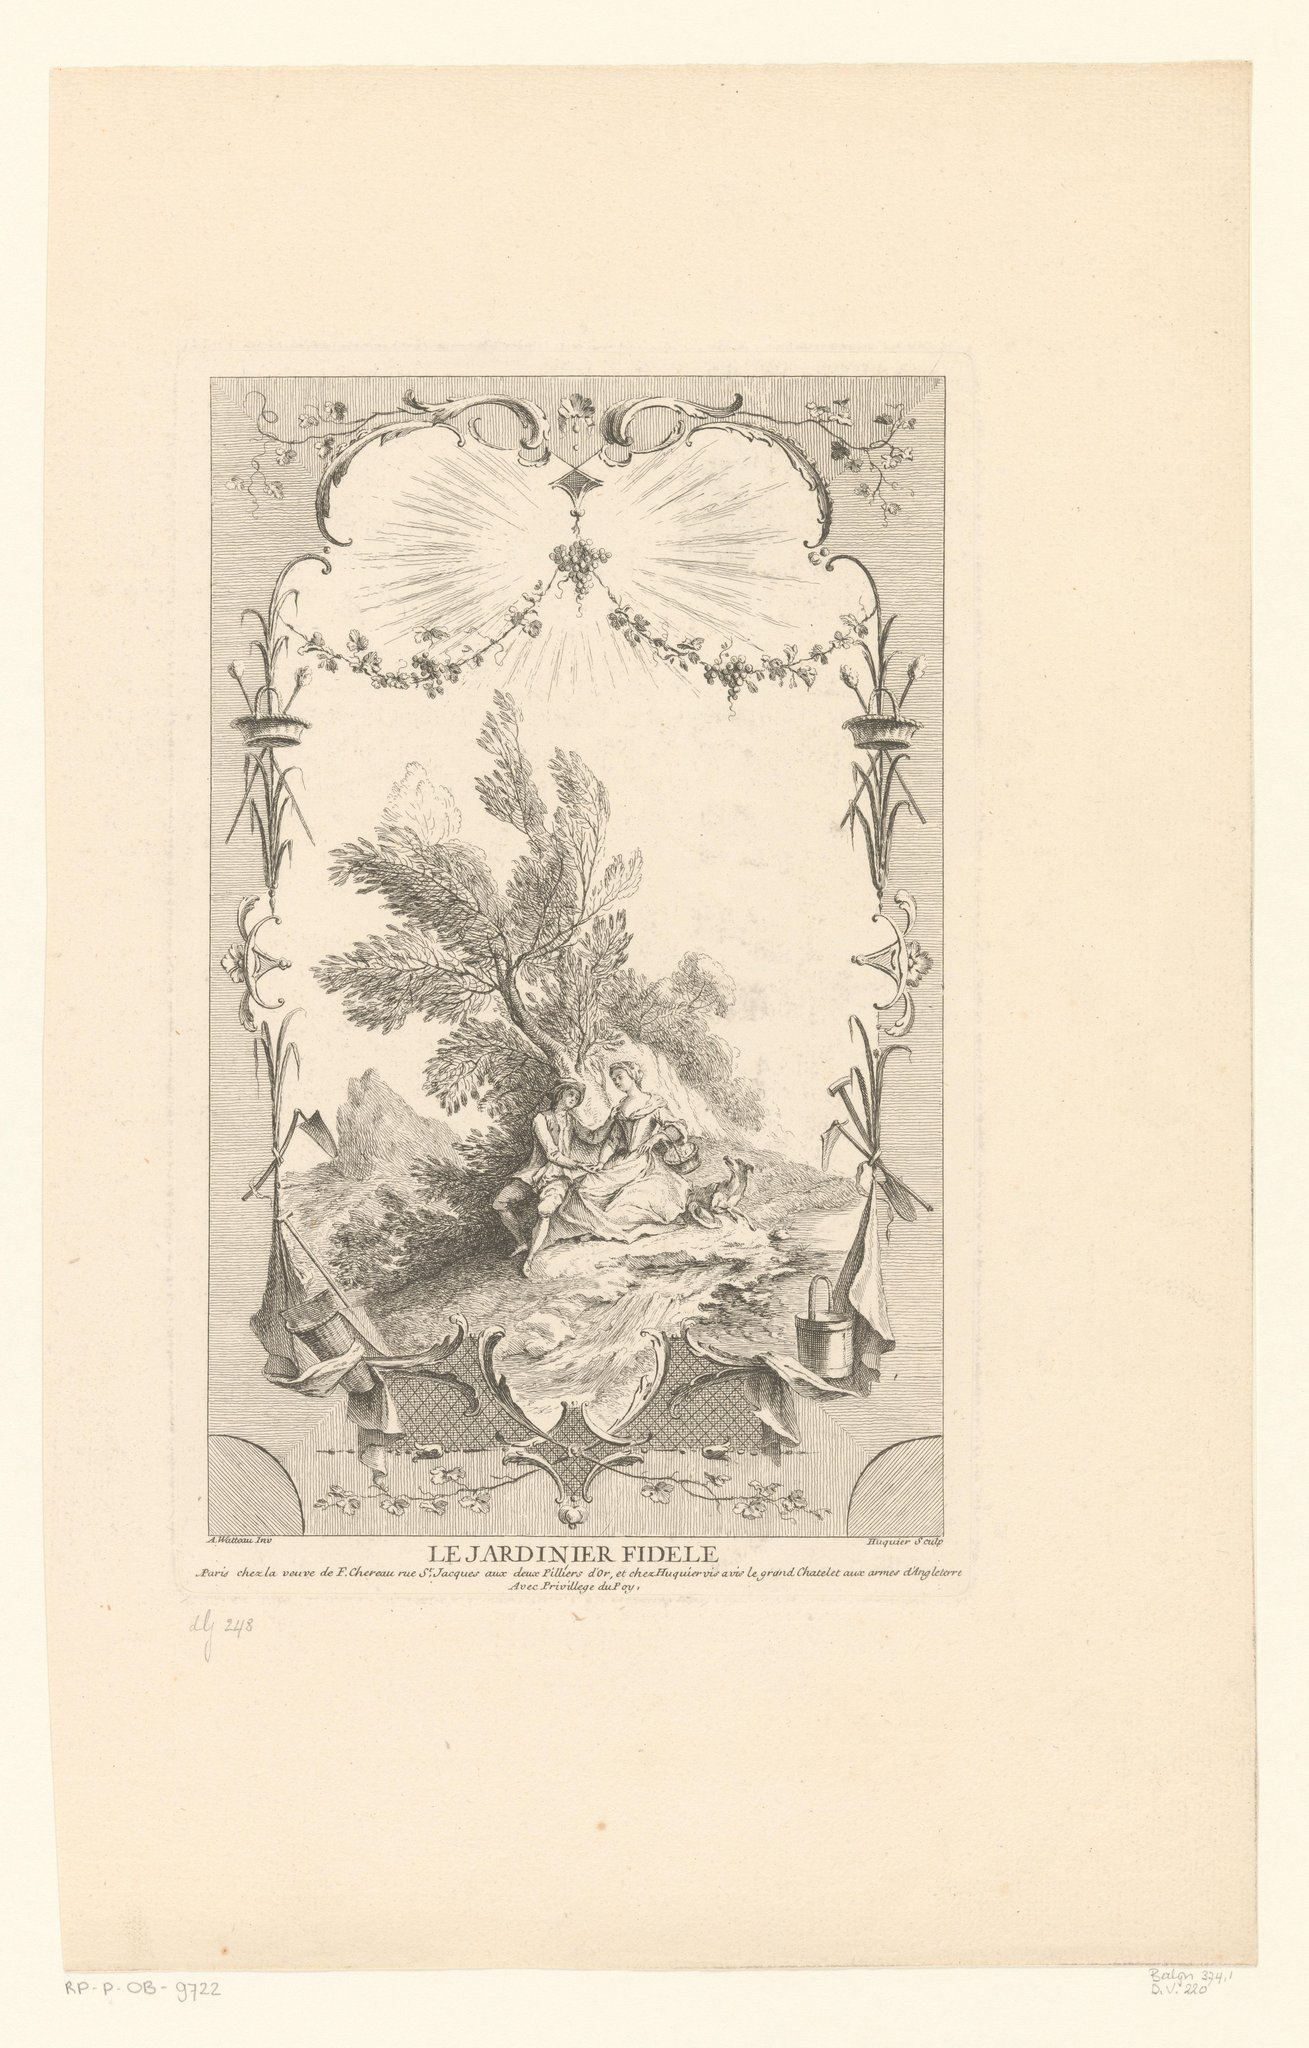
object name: ornament print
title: Jongeman en vrouw in landschap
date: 1729-1737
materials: paper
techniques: etching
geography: paris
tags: landscapes (+ landscape with figures, staffage)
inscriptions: collector's mark: Lugt 2228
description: In een landschap zit een jongeman naast een vrouw met een mand en een hond. Rondom de voorstelling een omlijsting met druiventros en -ranken, attributen behorend bij tuinieren en rocailles.